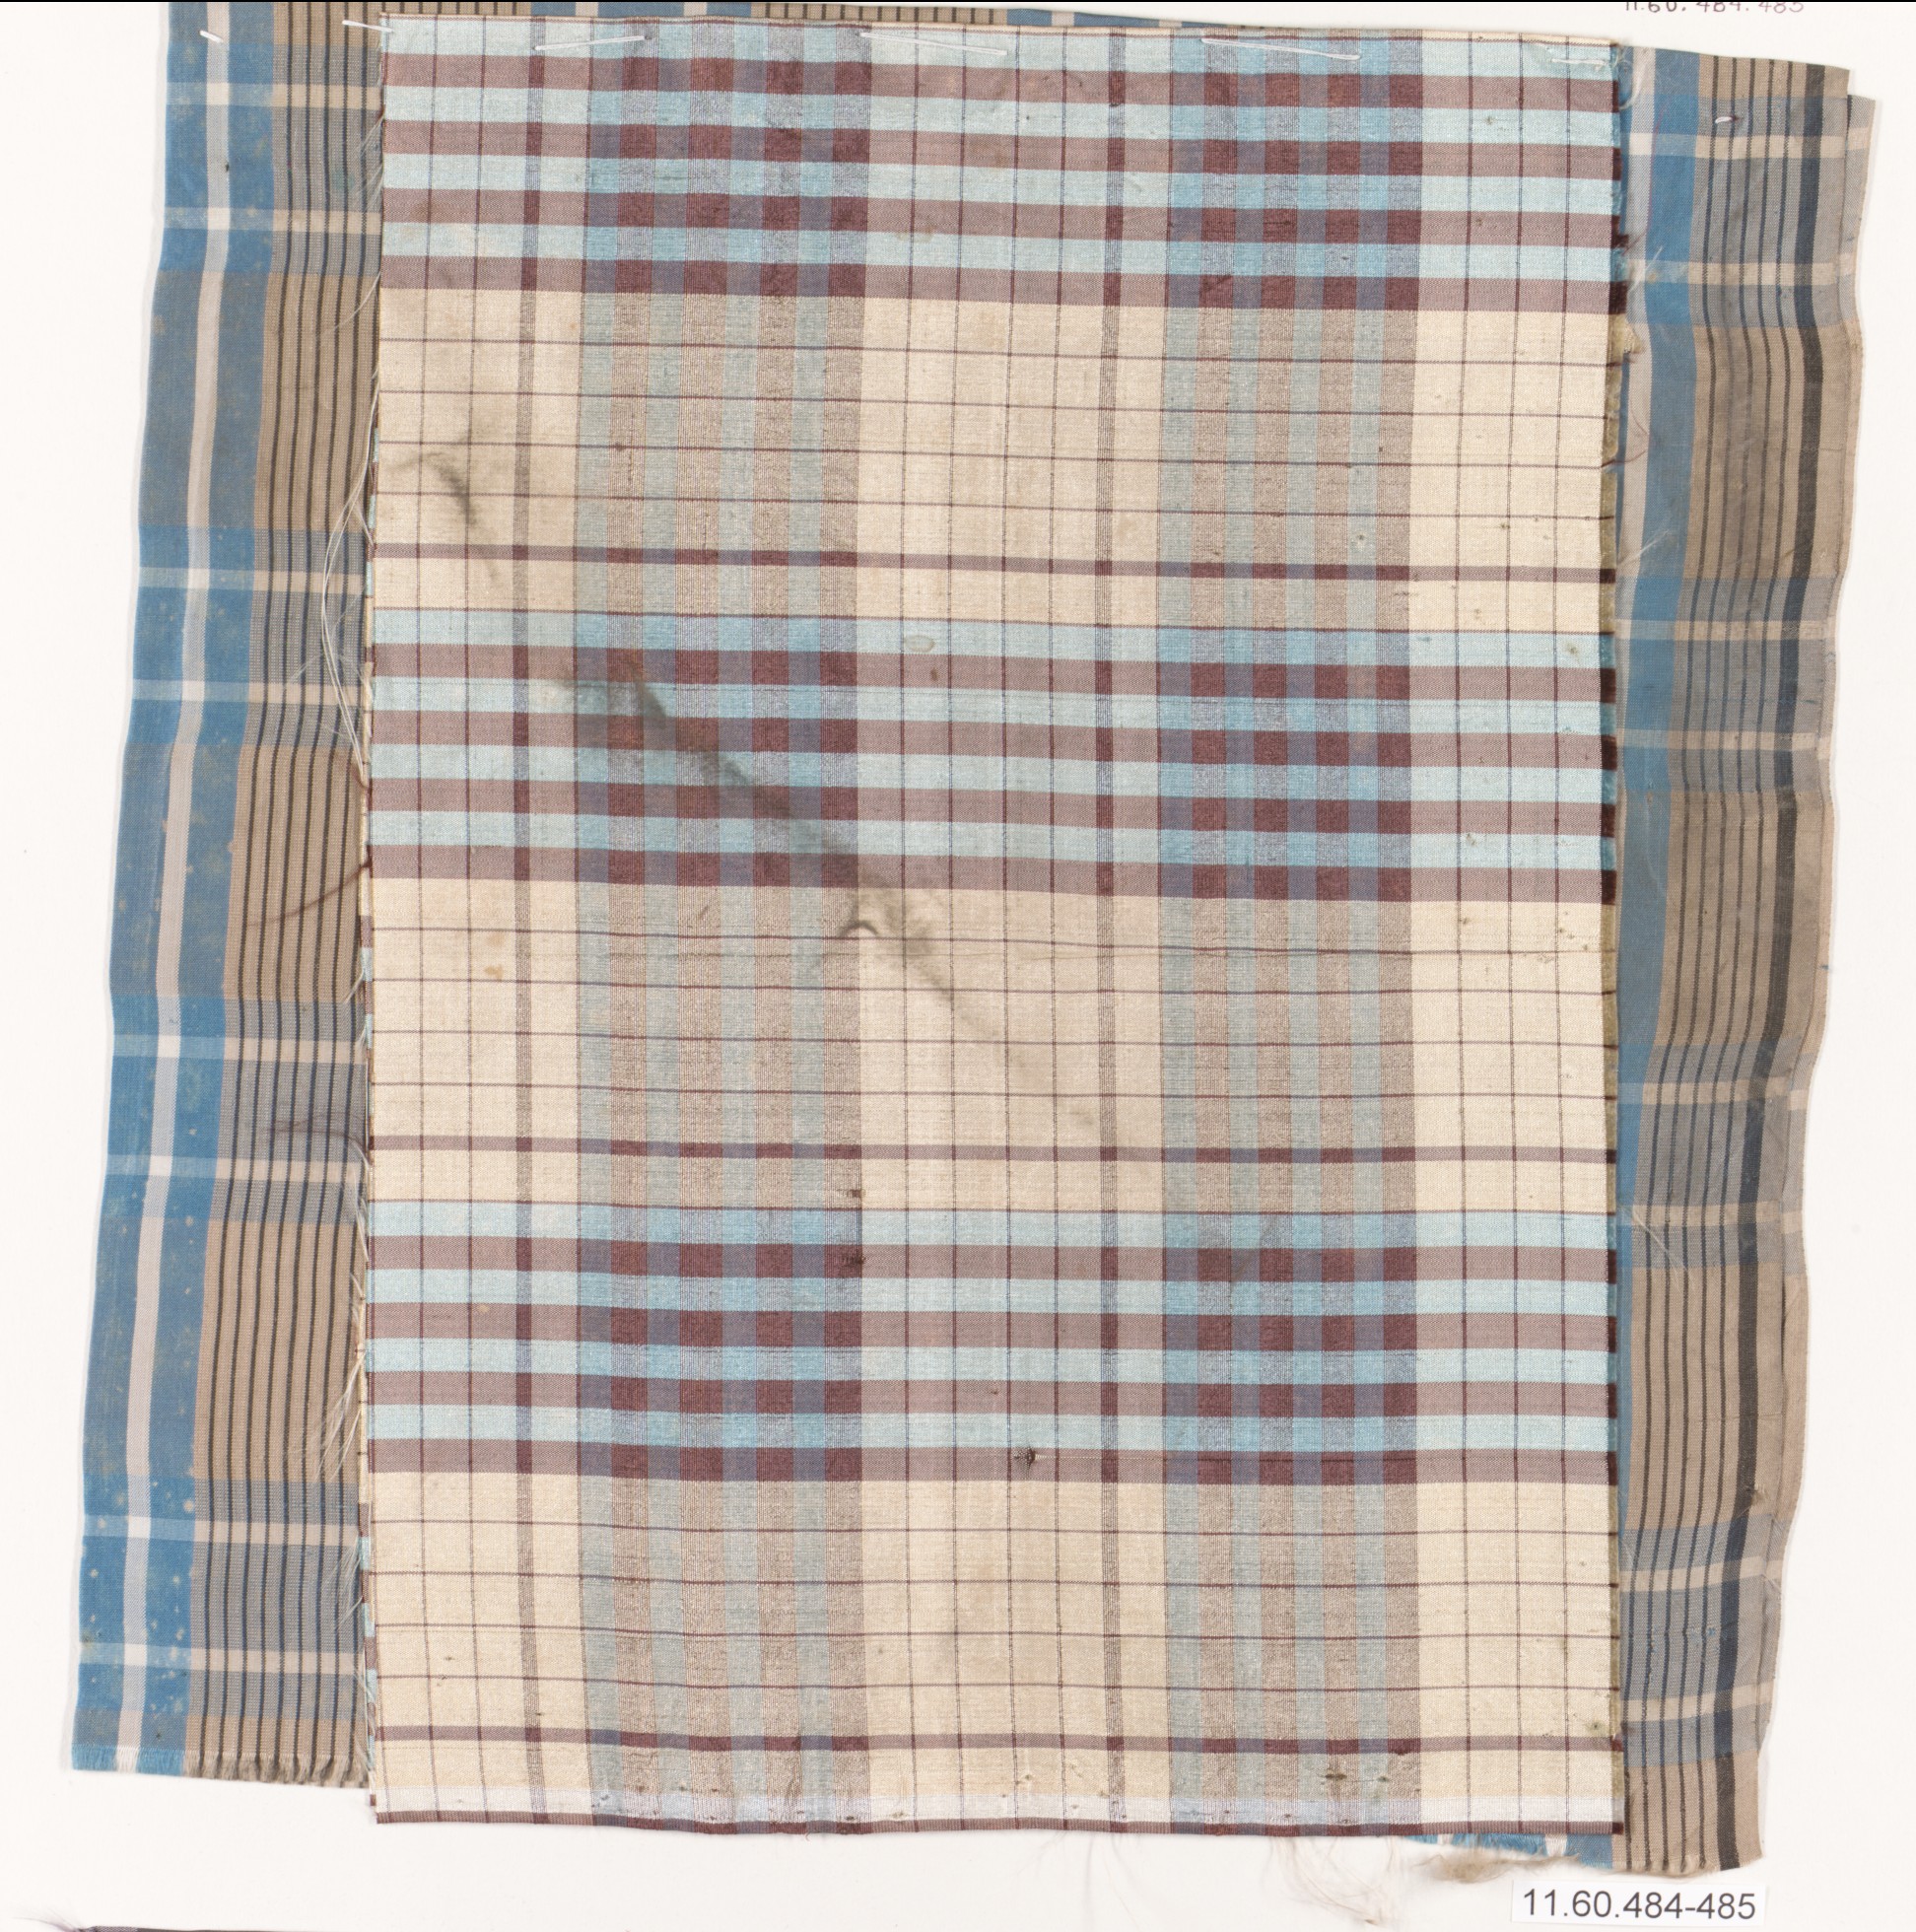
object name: sample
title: Samples (2)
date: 1834-1866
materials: silk